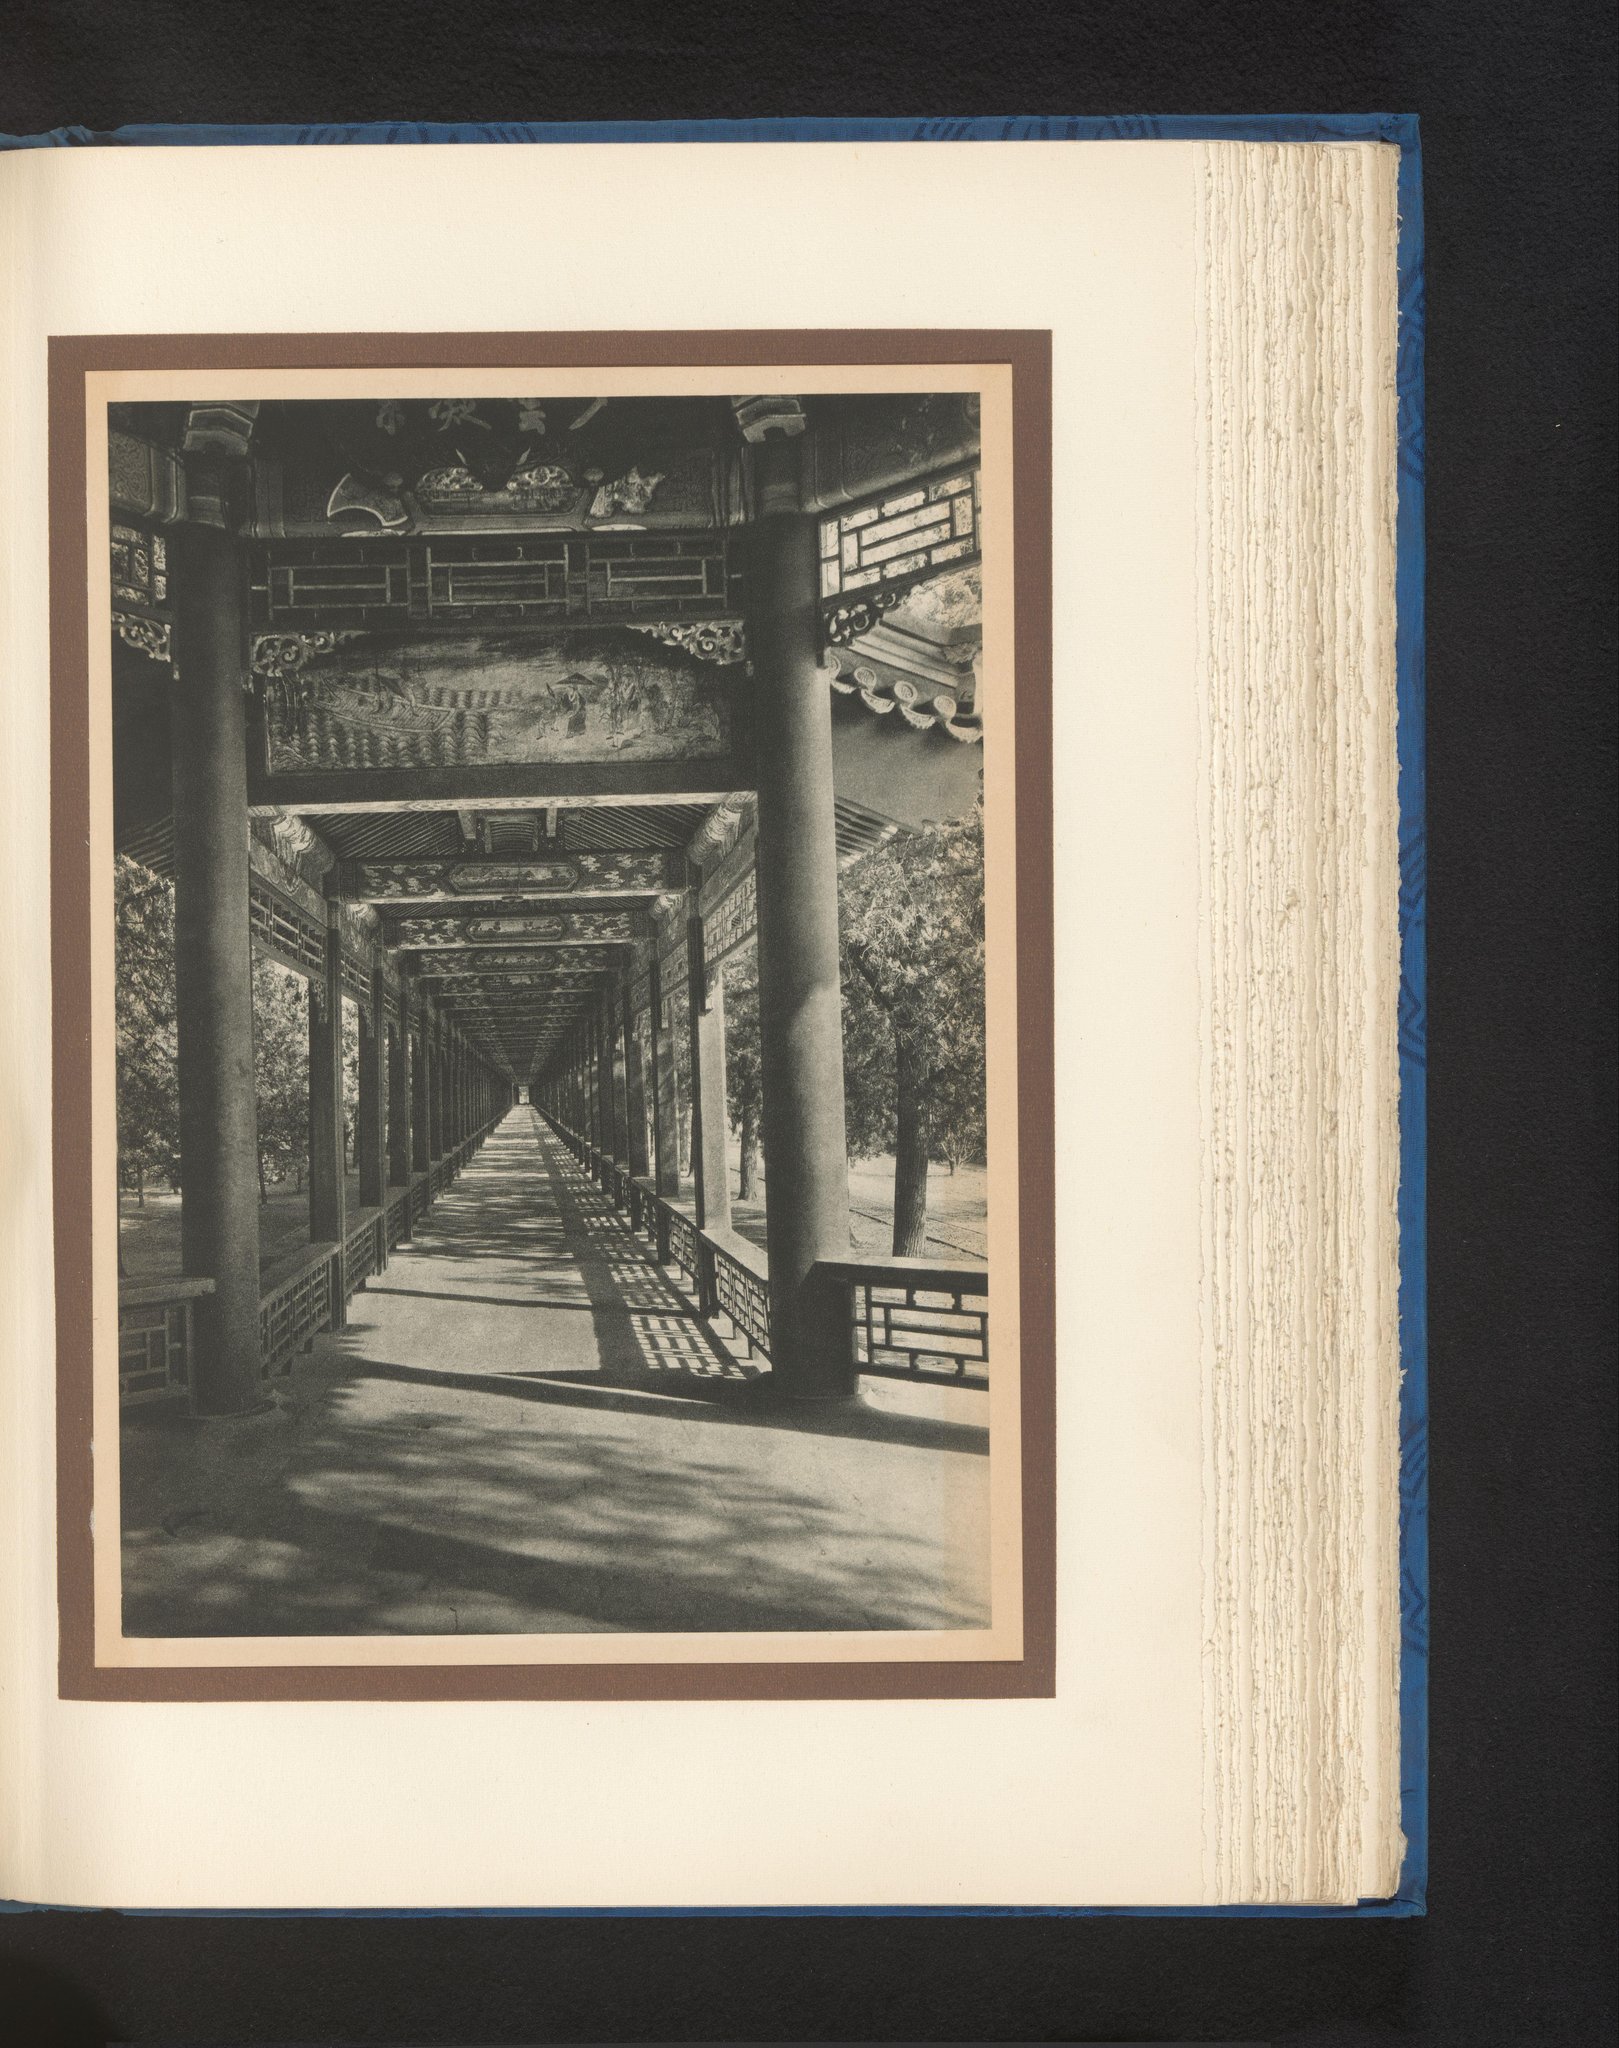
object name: page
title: Galerij bij het Zomerpaleis te Peking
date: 1915-1920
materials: paper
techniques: rotogravure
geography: beijing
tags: gallery (spacious corridor)